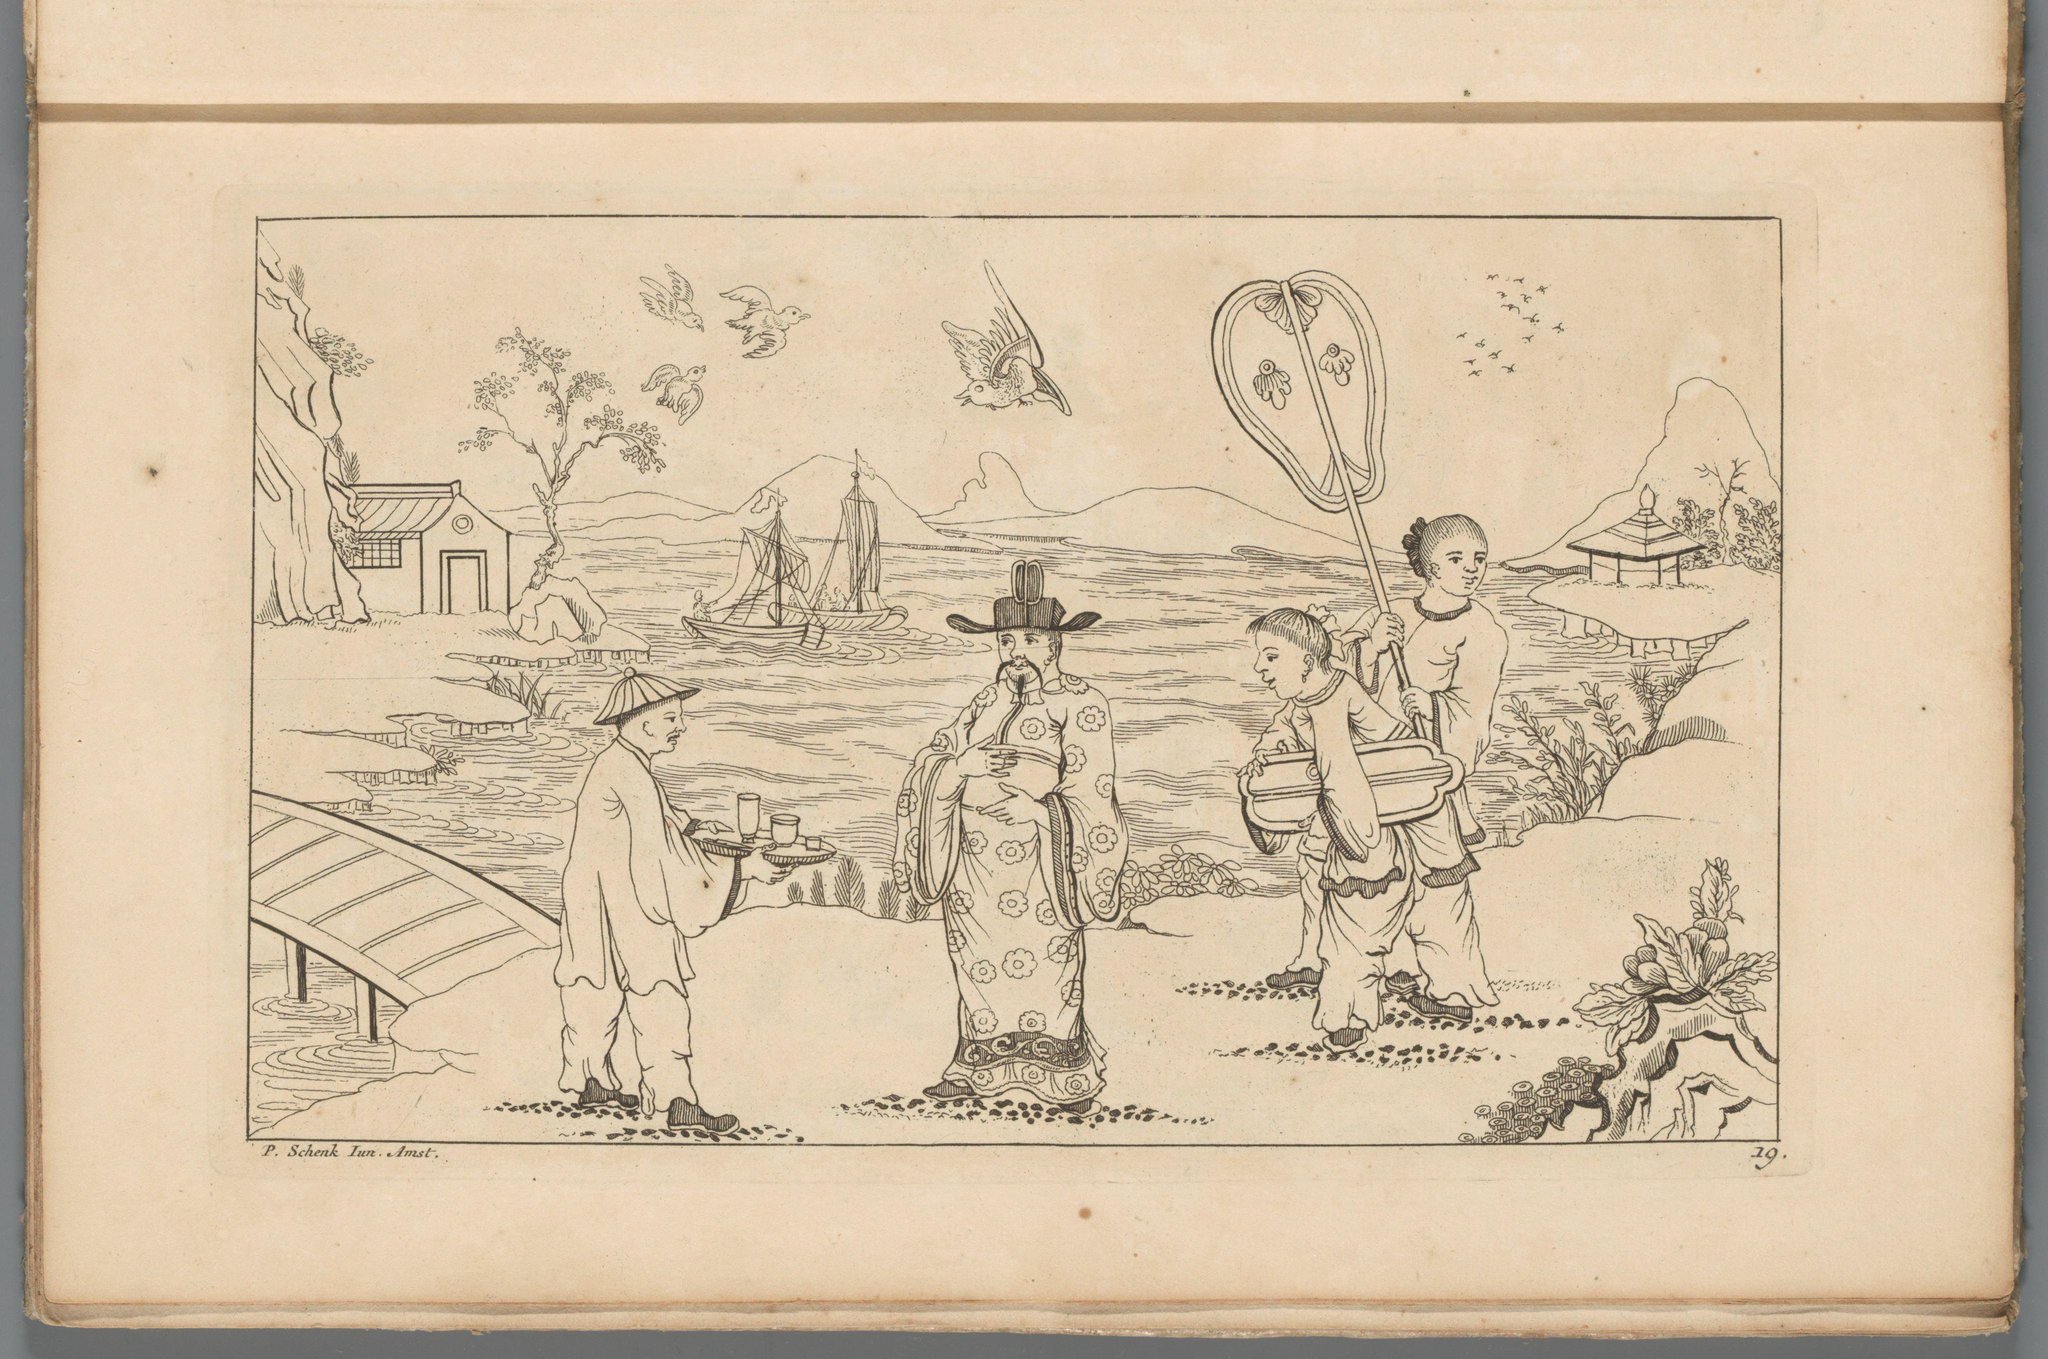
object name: album leaf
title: Nieuwe geinventeerde Sineesen met groote moeyte geteekent en in 't Ligt gegeven, door P. Schenk Jun (...), tweede deel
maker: pieter schenk (ii)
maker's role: draughtsman, print maker, publisher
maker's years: 1693-1775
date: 1727-1775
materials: paper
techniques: etching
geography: amsterdam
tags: tea-ceremony - cc - out of doors, chinese, water course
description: Landschap met een Chinese heer die van een bediende thee op een dienblad krijgt aangeboden. Achter de heer twee vrouwen, waarvan een met parasol. Op de achtergrond twee zeilschepen op het water. Prent maakt deel uit van een album.